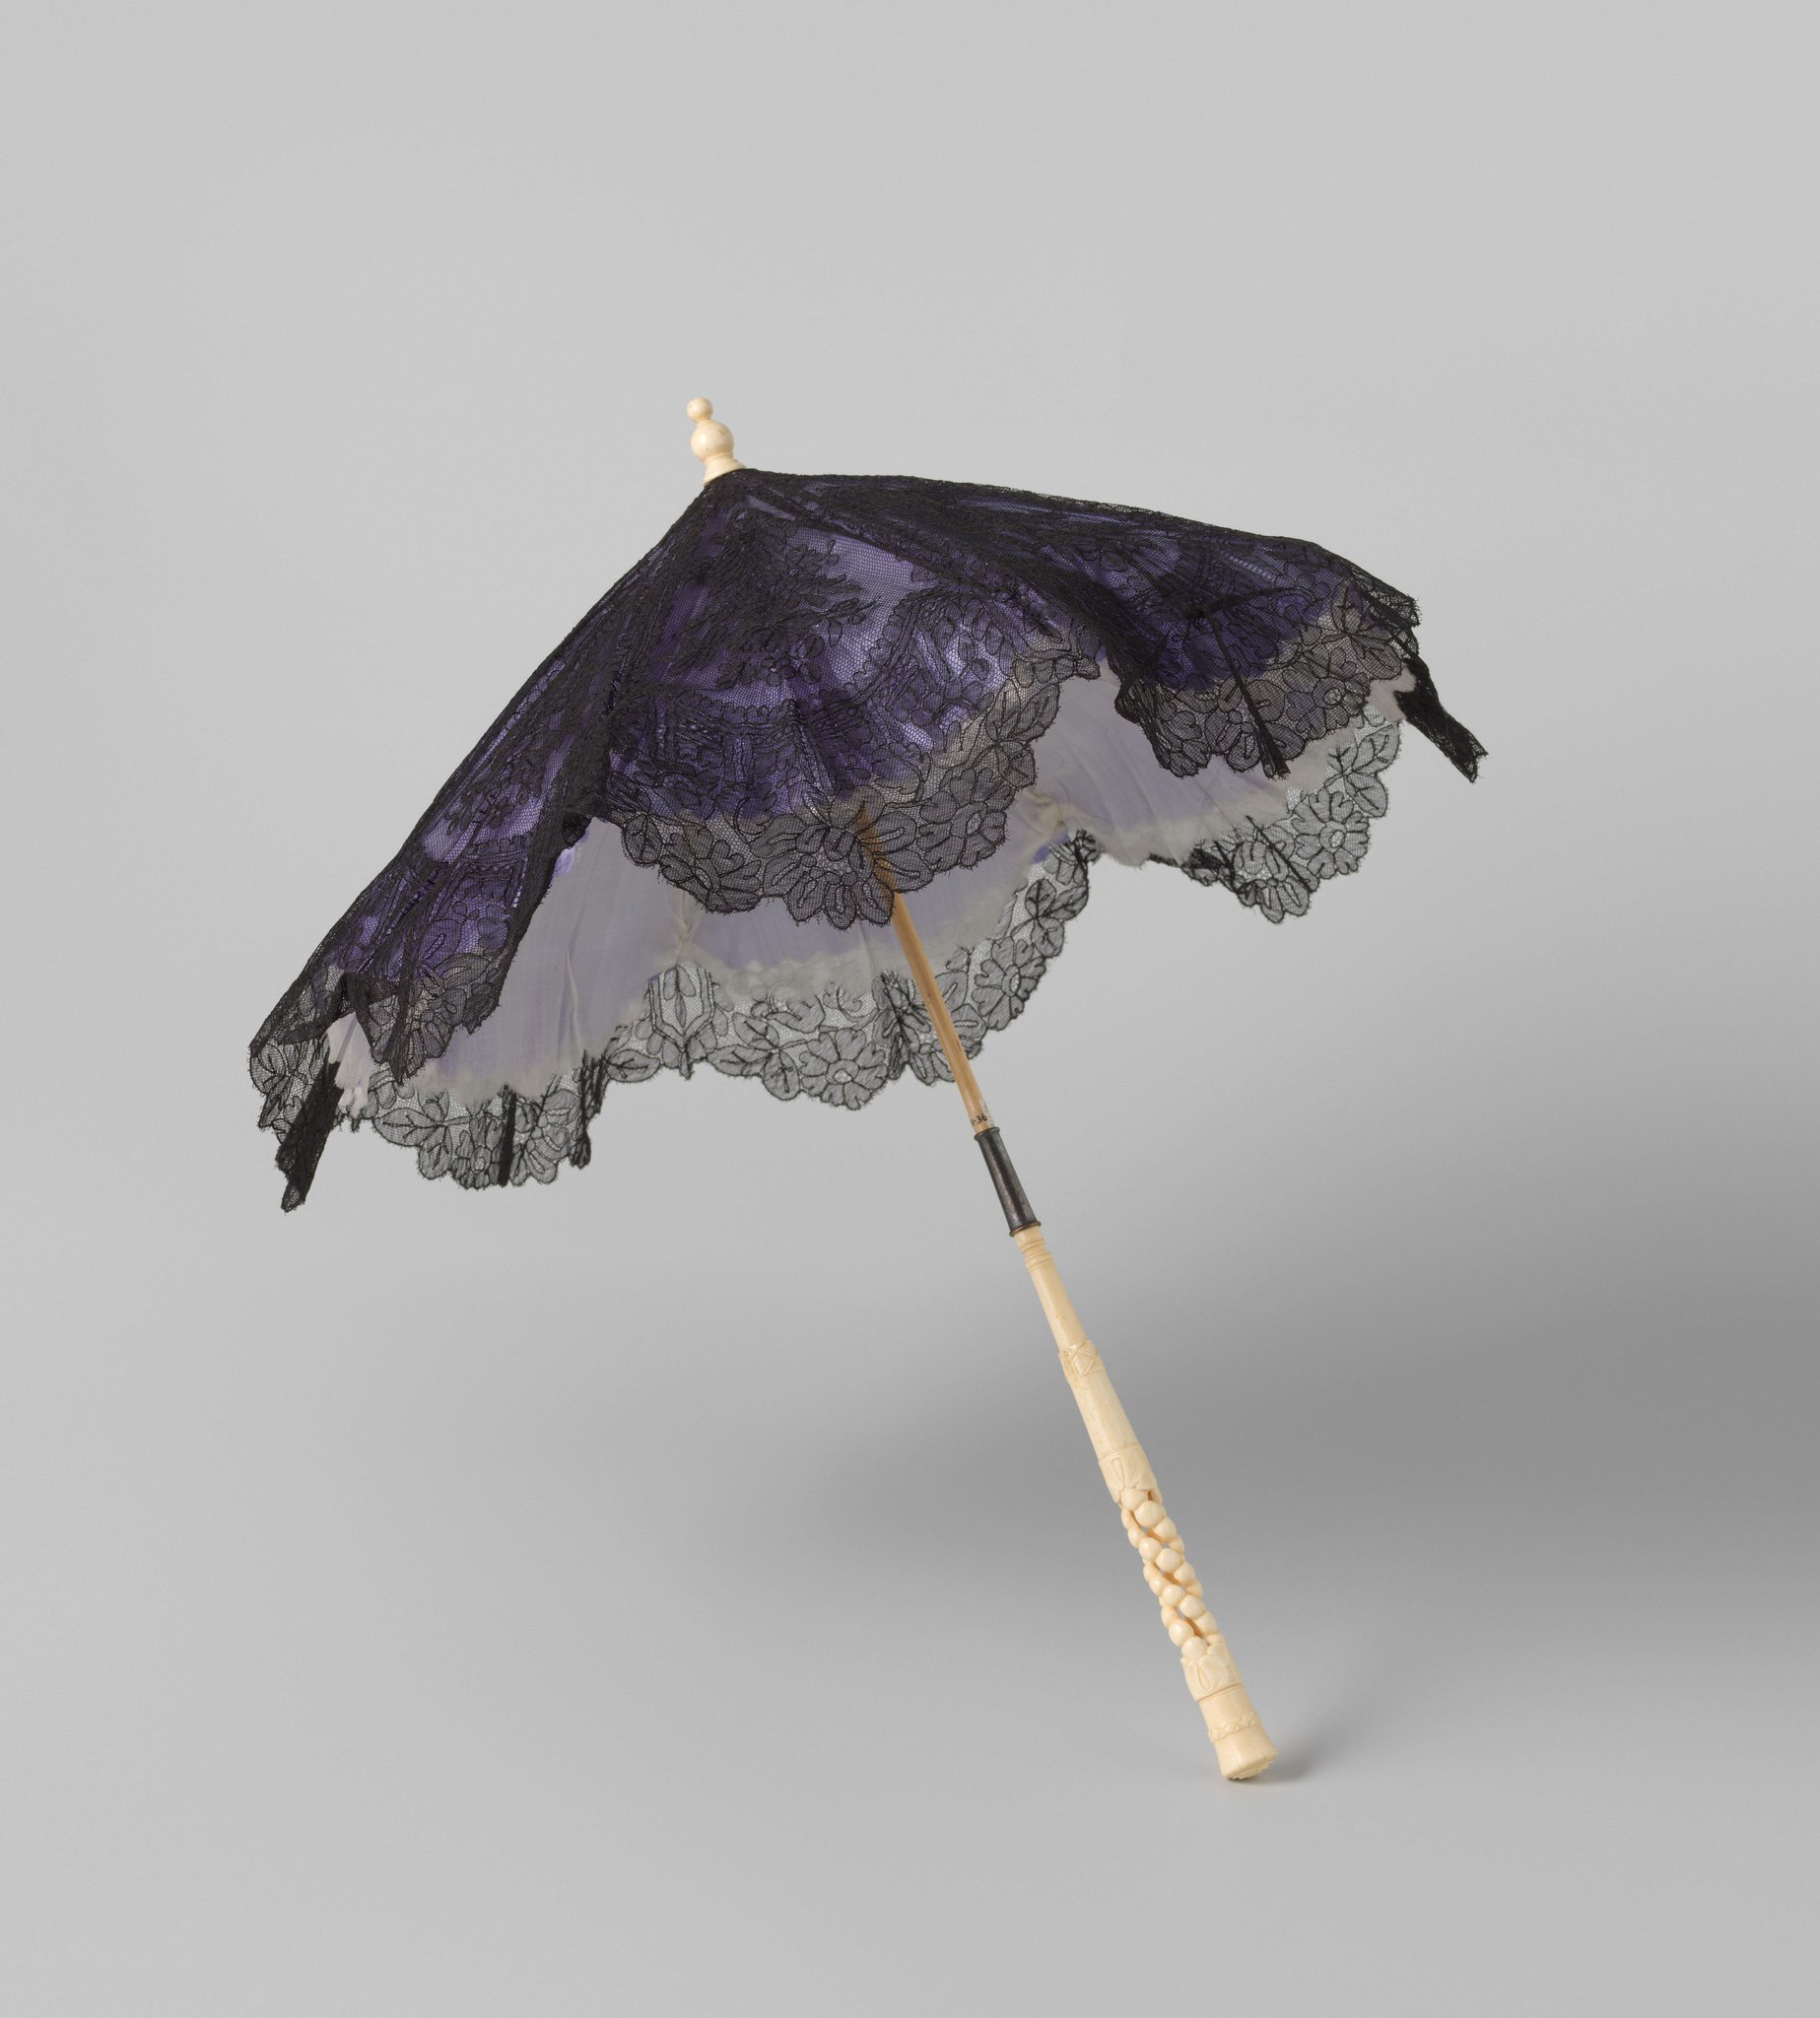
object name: carriage parasol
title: Rijtuigparasol met dek van machinale Chantilly-kant op lavendelblauwe tafzijde, opengewerkte stok van been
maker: Anonymous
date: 1840-1860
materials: bone, silk, steel, wood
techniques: casting, lace, cutting, manufacturing, lacquer, weave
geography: france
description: Rijtuigparasol met dek van zwarte machinale Chantilly-kant met een patroon van bloemtakken, bloemen en bladeren. Onder de Chantilly-kant een lavendelblauwe tafzijde. Voering van witte pongé-zijde met blind ingestanst bloemmotief in de schulpen. Gedeeltelijk opengewerkt, getorst benen handvat, met halverwege een stalen ring. Bovenste deel van de stok is van gelakt hout. Baleinen van donker hout. Bovenop een benen knop.